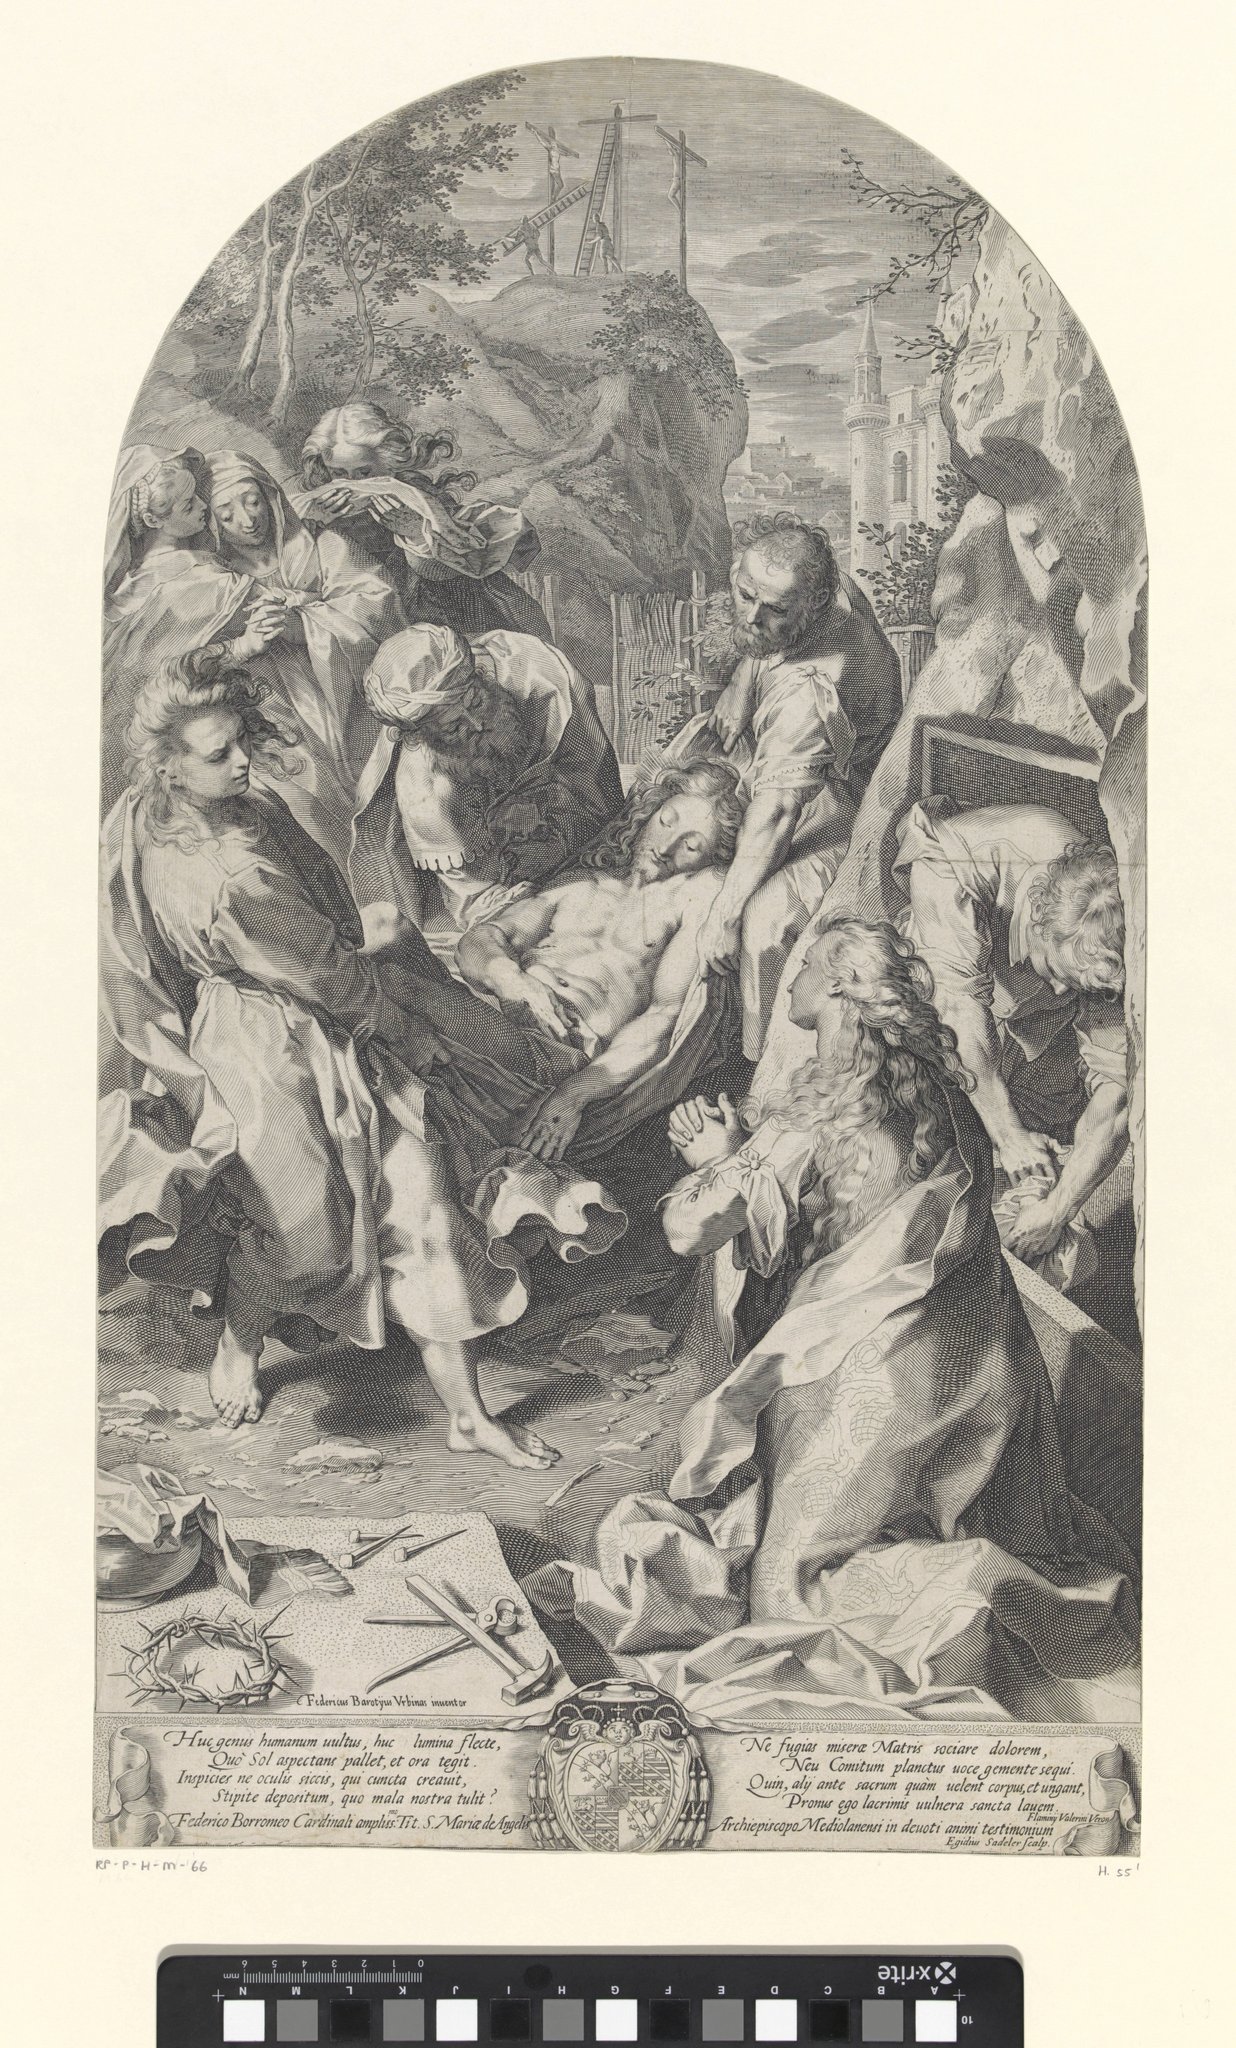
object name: print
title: Graflegging van Christus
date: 1591-1615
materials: paper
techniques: engraving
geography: urbino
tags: christ's entombment (possibly by angels)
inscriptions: collector's mark: Lugt 11, collector's mark: Lugt 10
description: Het lichaam van Christus wordt door drie mannen, onder wie Jozef van Arimatea en Nikodemus, naar zijn geopende graftombe gedragen. Achter hen rouwt Maria samen met twee vrouwen. Vooraan knielt een vrouw met gevouwen handen, Maria Magdalena(?). Links vooraan liggen de martelwerktuigen. In de verte de drie kruisen op een rots. Onder de voorstelling een achtregelige, Latijnse tekst en daaronder de opdracht, eveneens in het Latijn. Midden onder het wapen van kardinaal Borromeo.